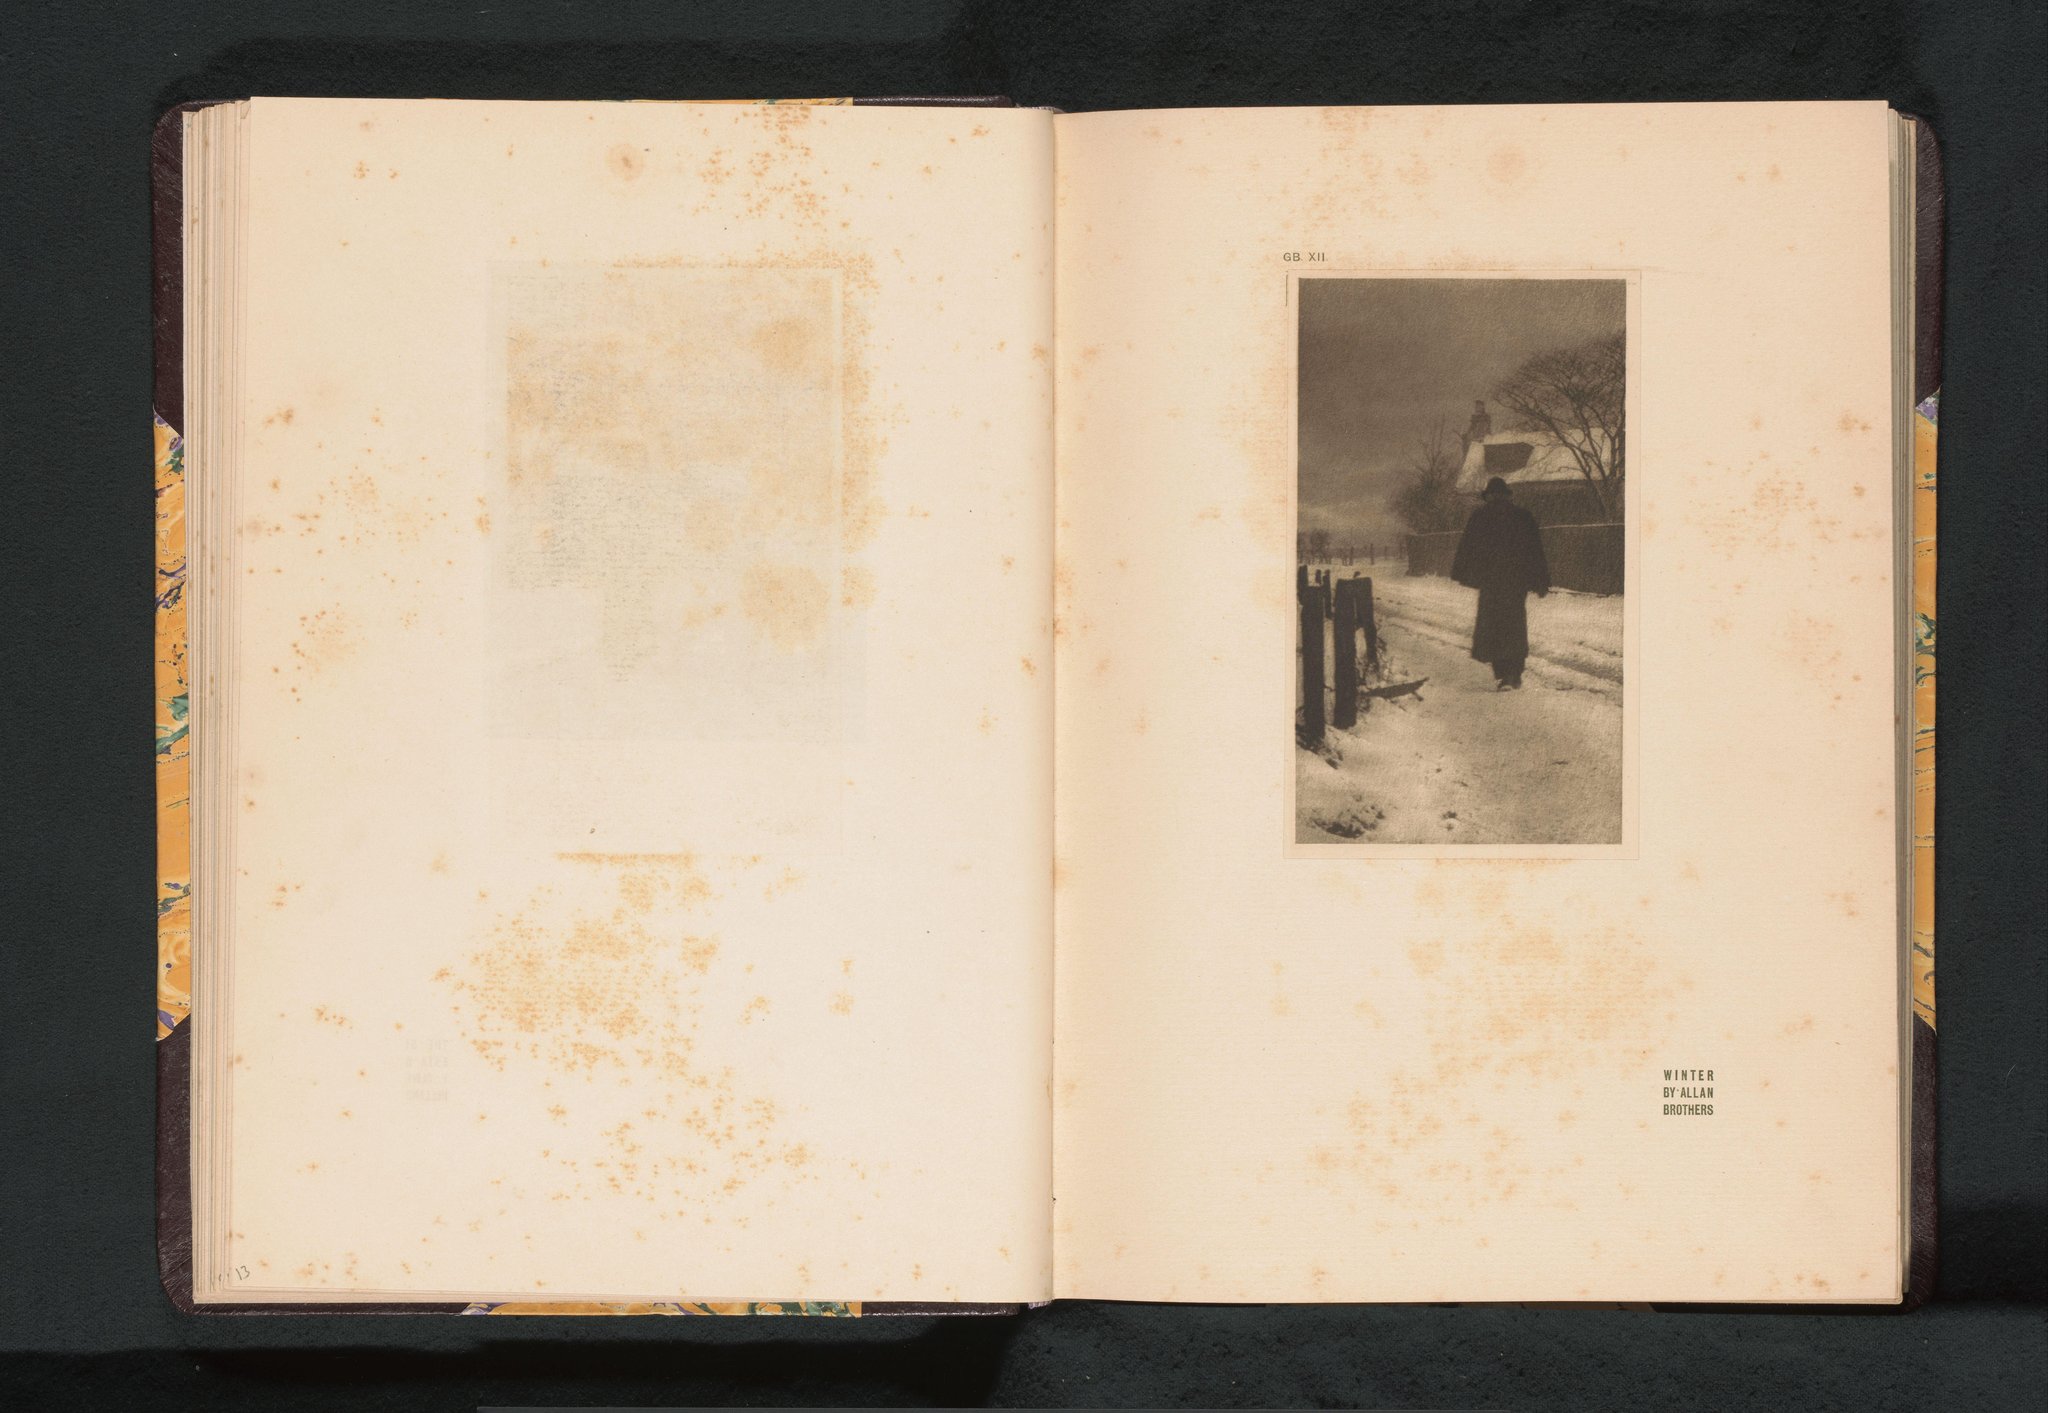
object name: photomechanical print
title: Winterlandschap met een man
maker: Anonymous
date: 1900-1905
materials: paper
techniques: photoaquatint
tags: winter landscape; landscape symbolizing winter (the four seasons of the year)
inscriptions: inscription: ‘GB. XII.’, inscription: ‘Winter by Allan Brothers’